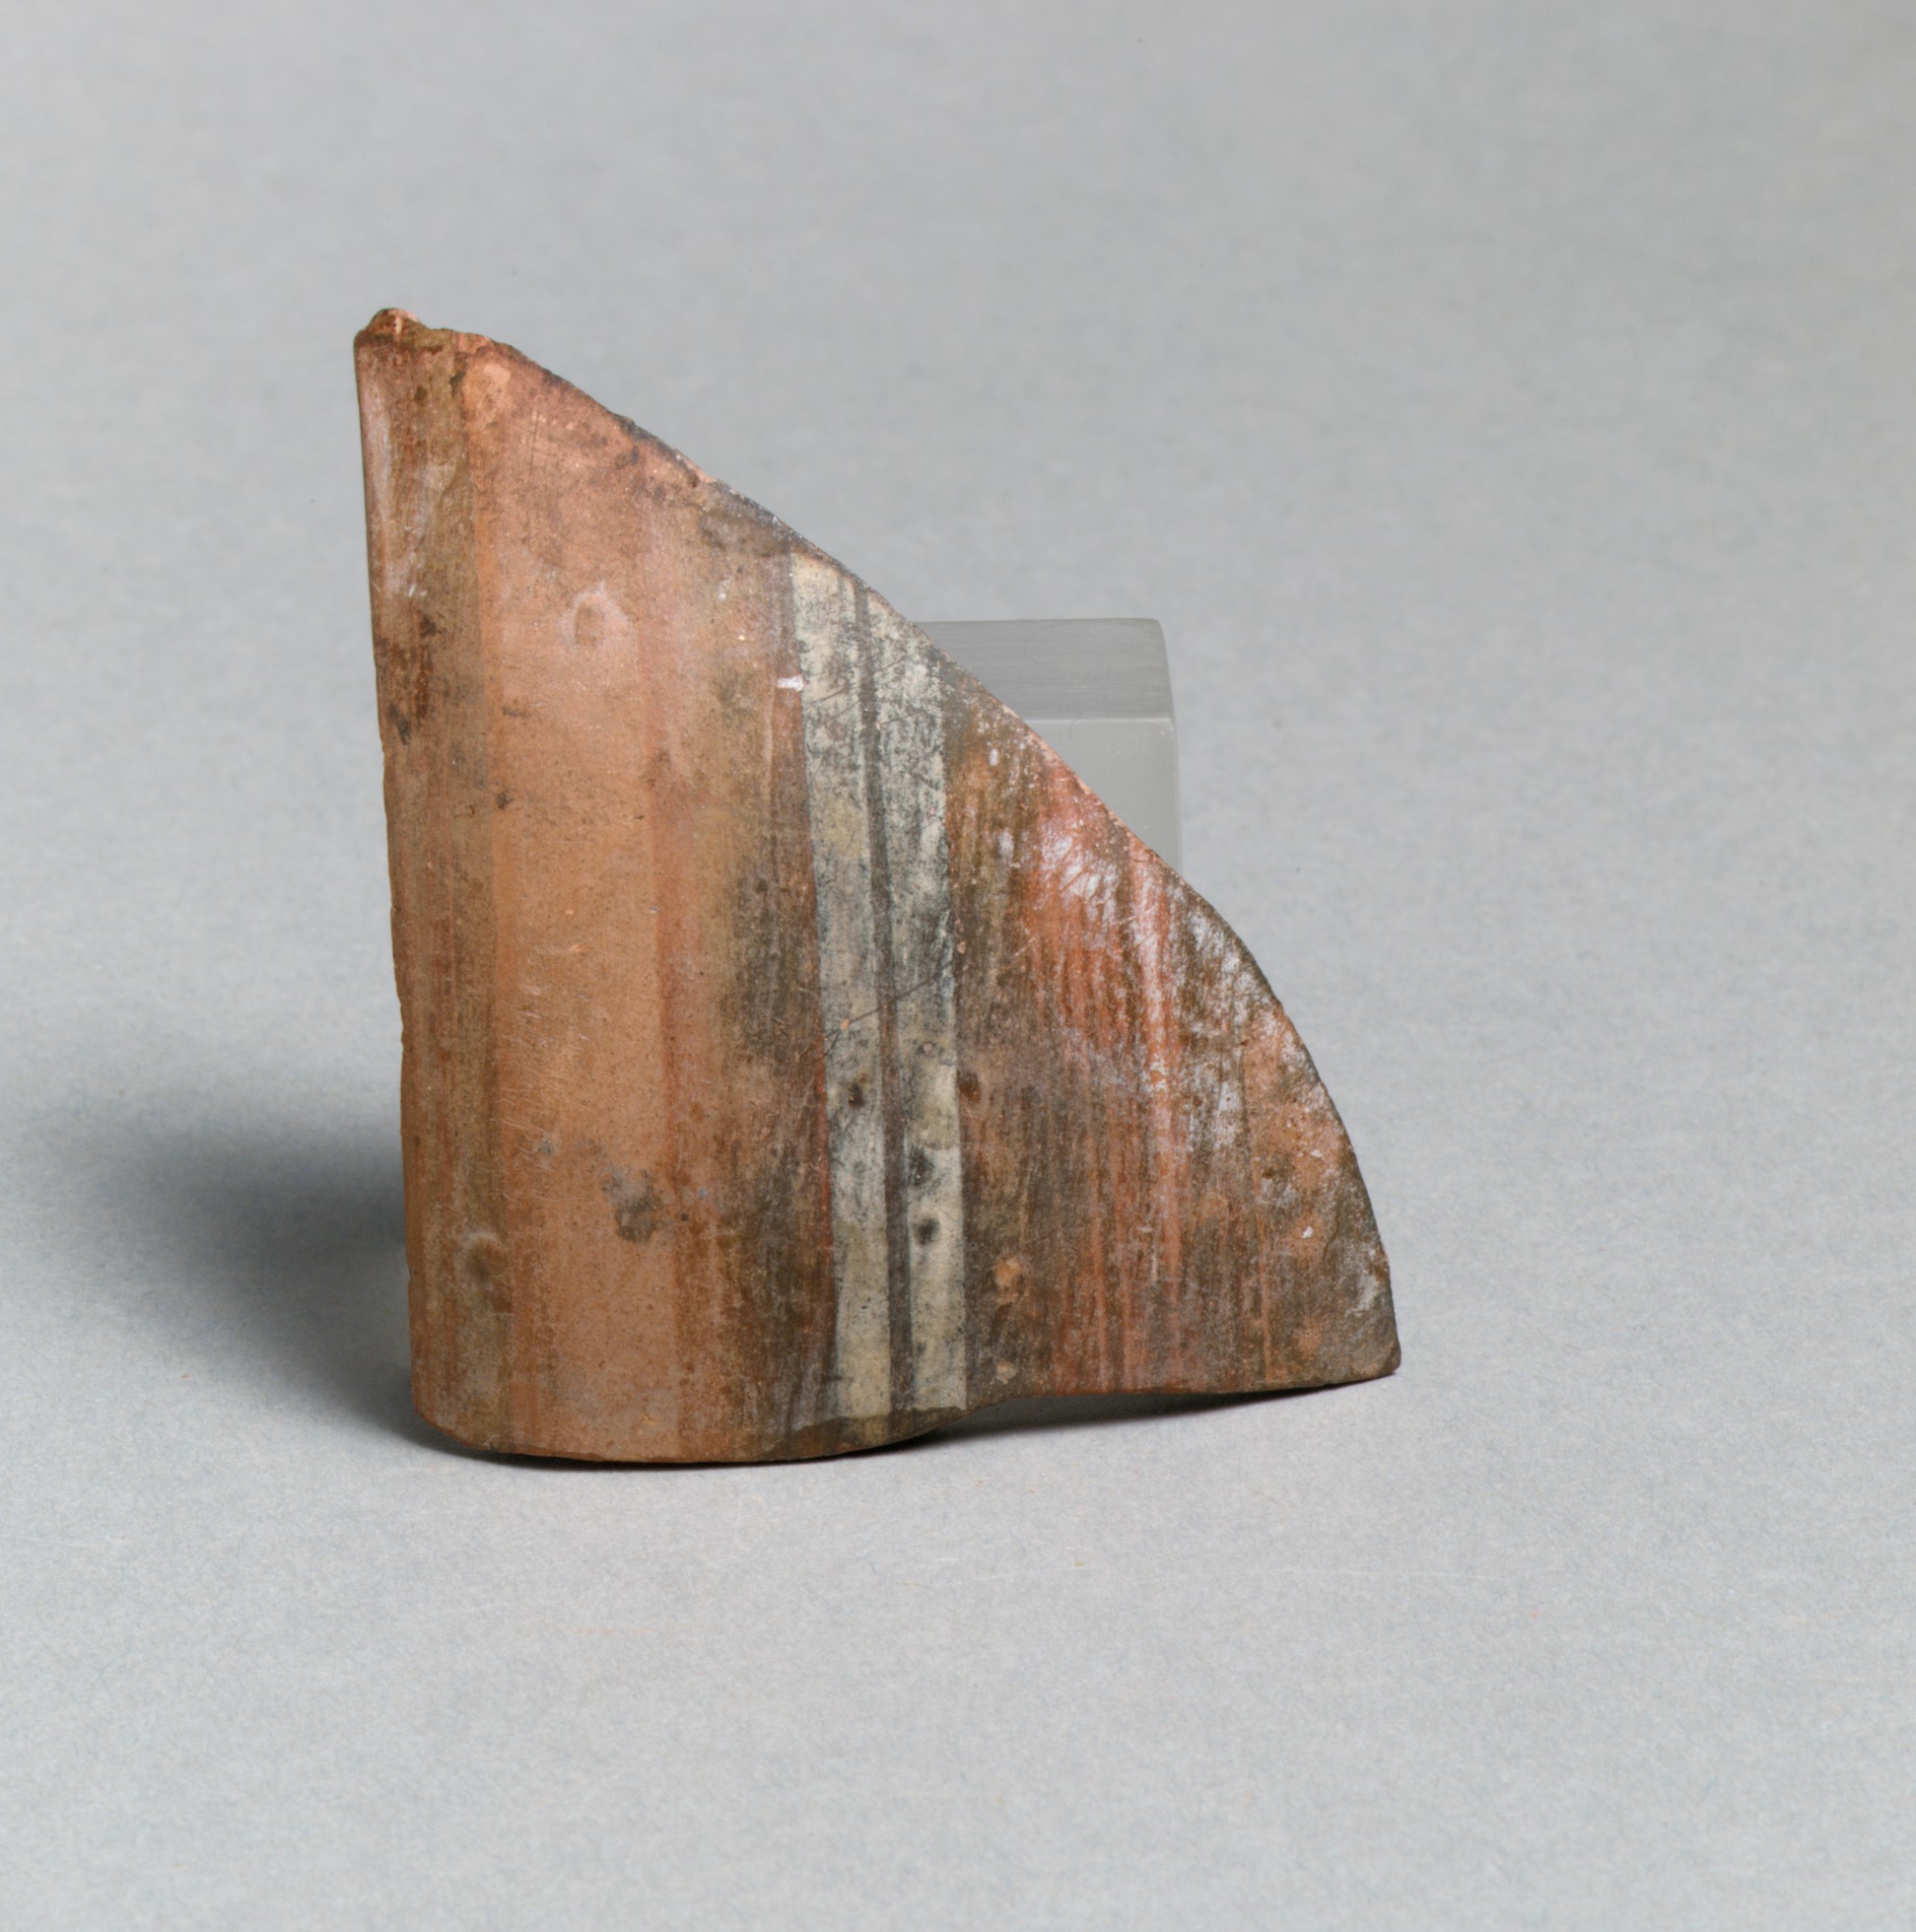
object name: vase fragment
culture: greek or lydian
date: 900-30 BCE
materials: terracotta